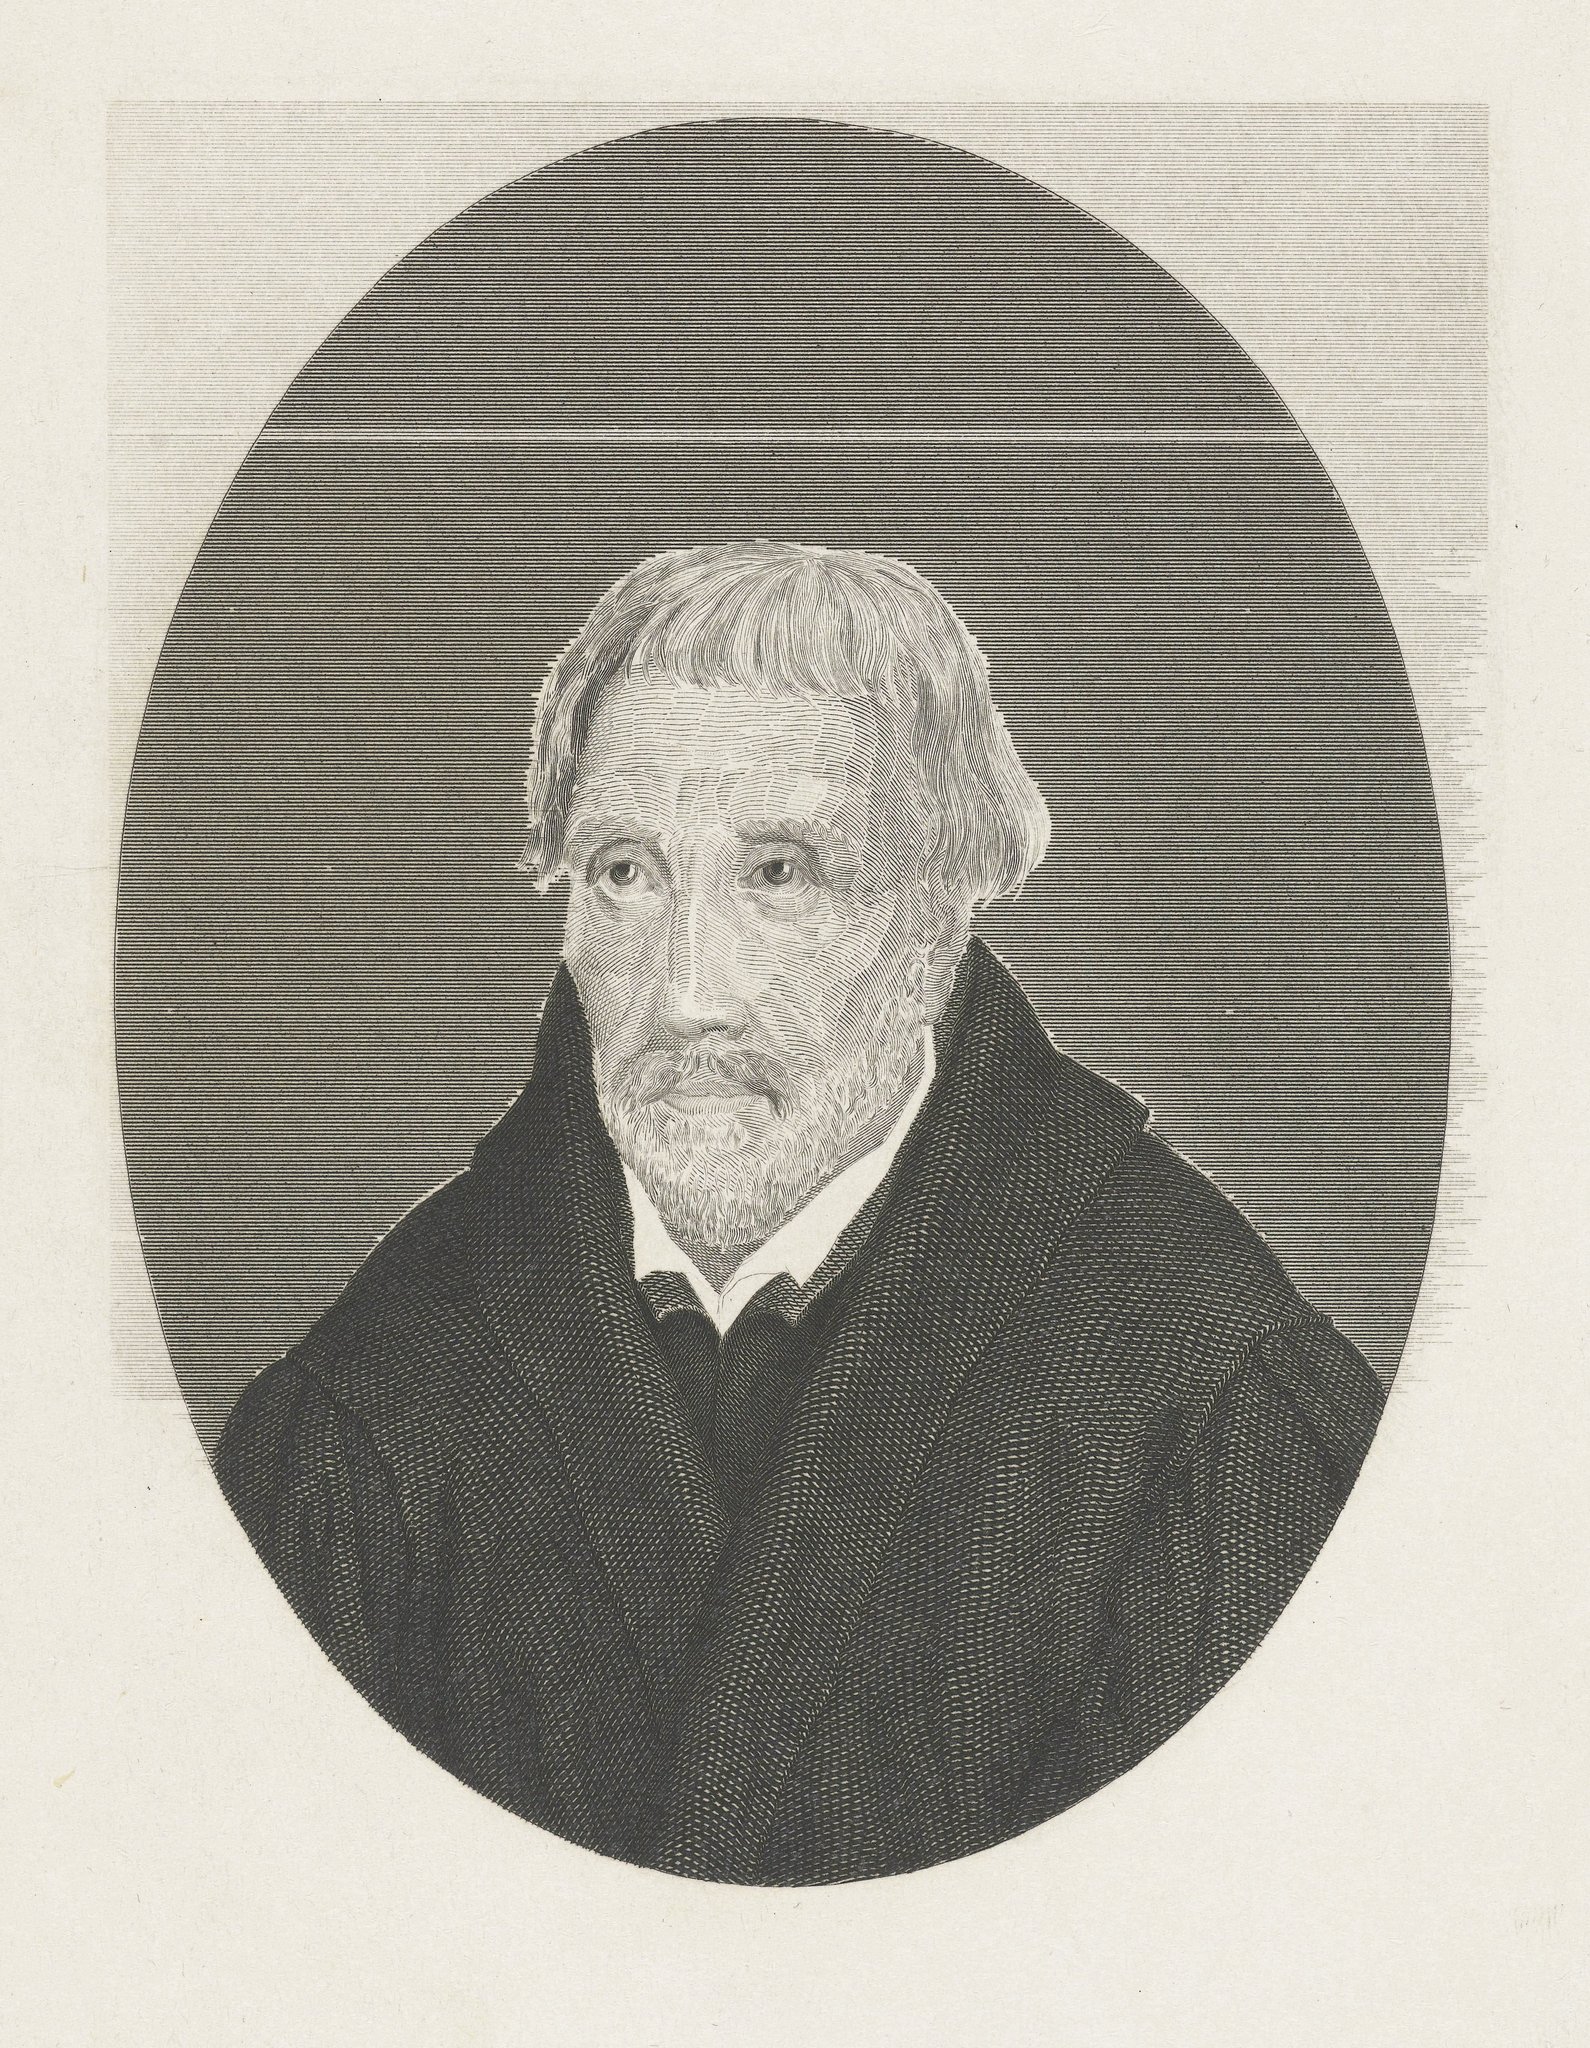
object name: print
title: Mansbuste in ovaal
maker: henricus wilhelmus couwenberg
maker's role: draughtsman, print maker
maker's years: 1814-1845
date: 1829-1845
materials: paper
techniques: engraving, etching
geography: amsterdam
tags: anonymous historical person portrayed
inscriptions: collector's mark: Lugt 2228